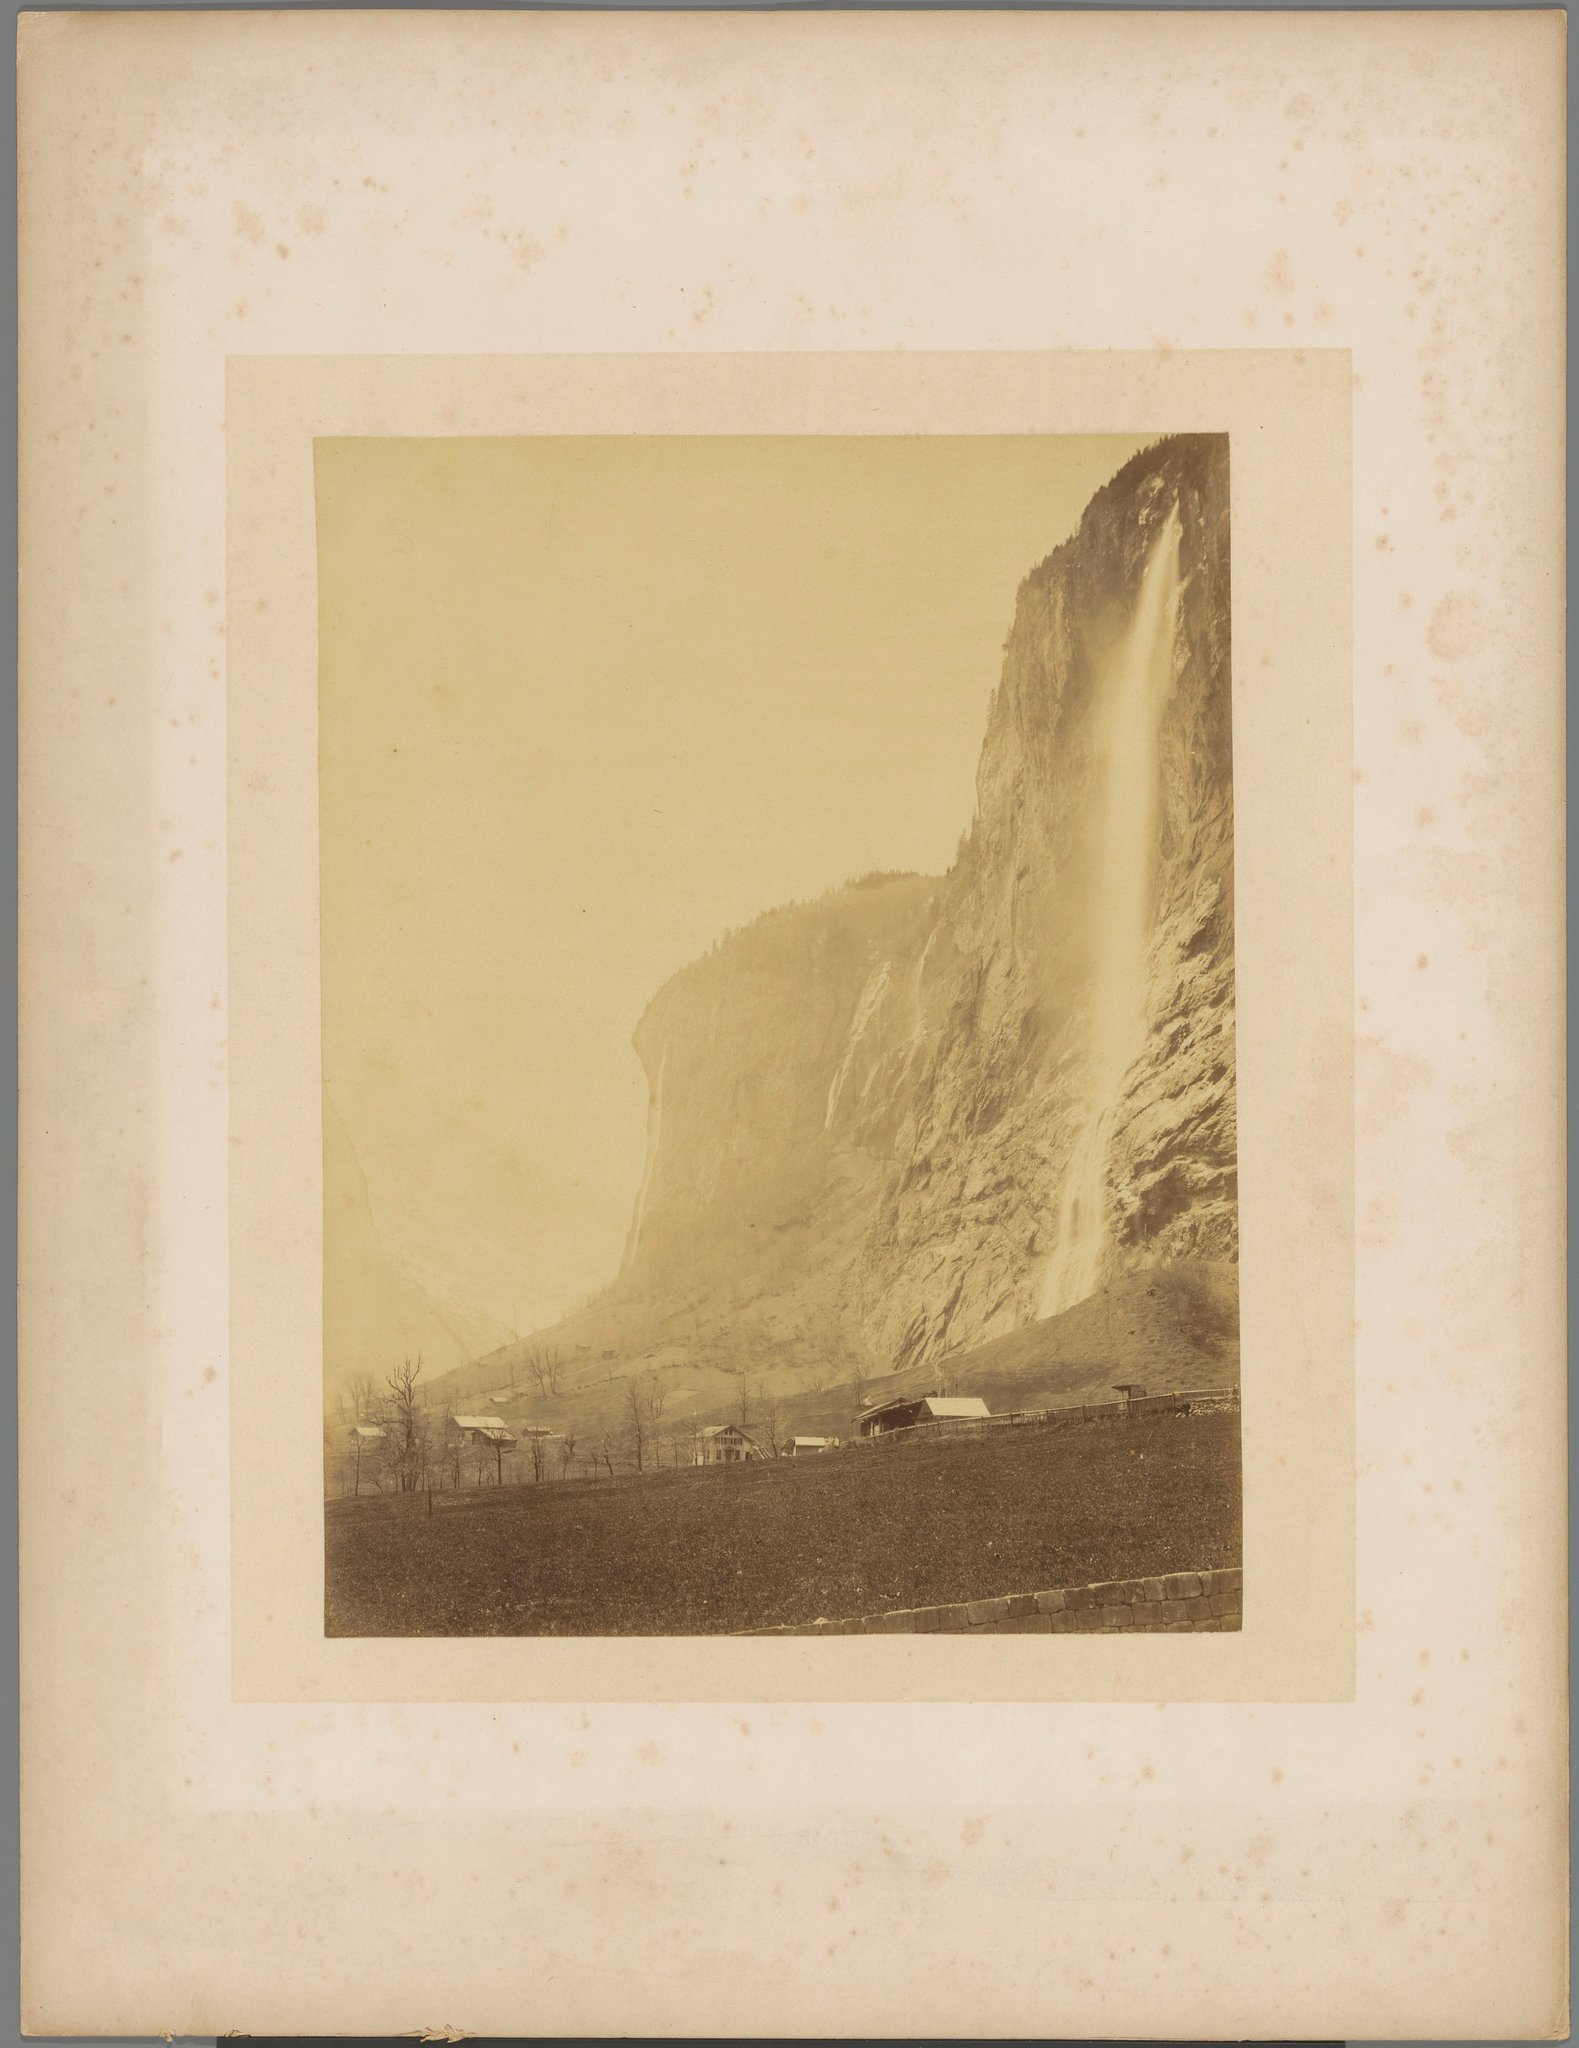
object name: photograph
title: Staubbachwaterval bij Lauterbrunnen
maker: Anonymous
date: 1860-1890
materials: cardboard, paper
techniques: albumen print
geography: lauterbrunnen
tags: waterfall